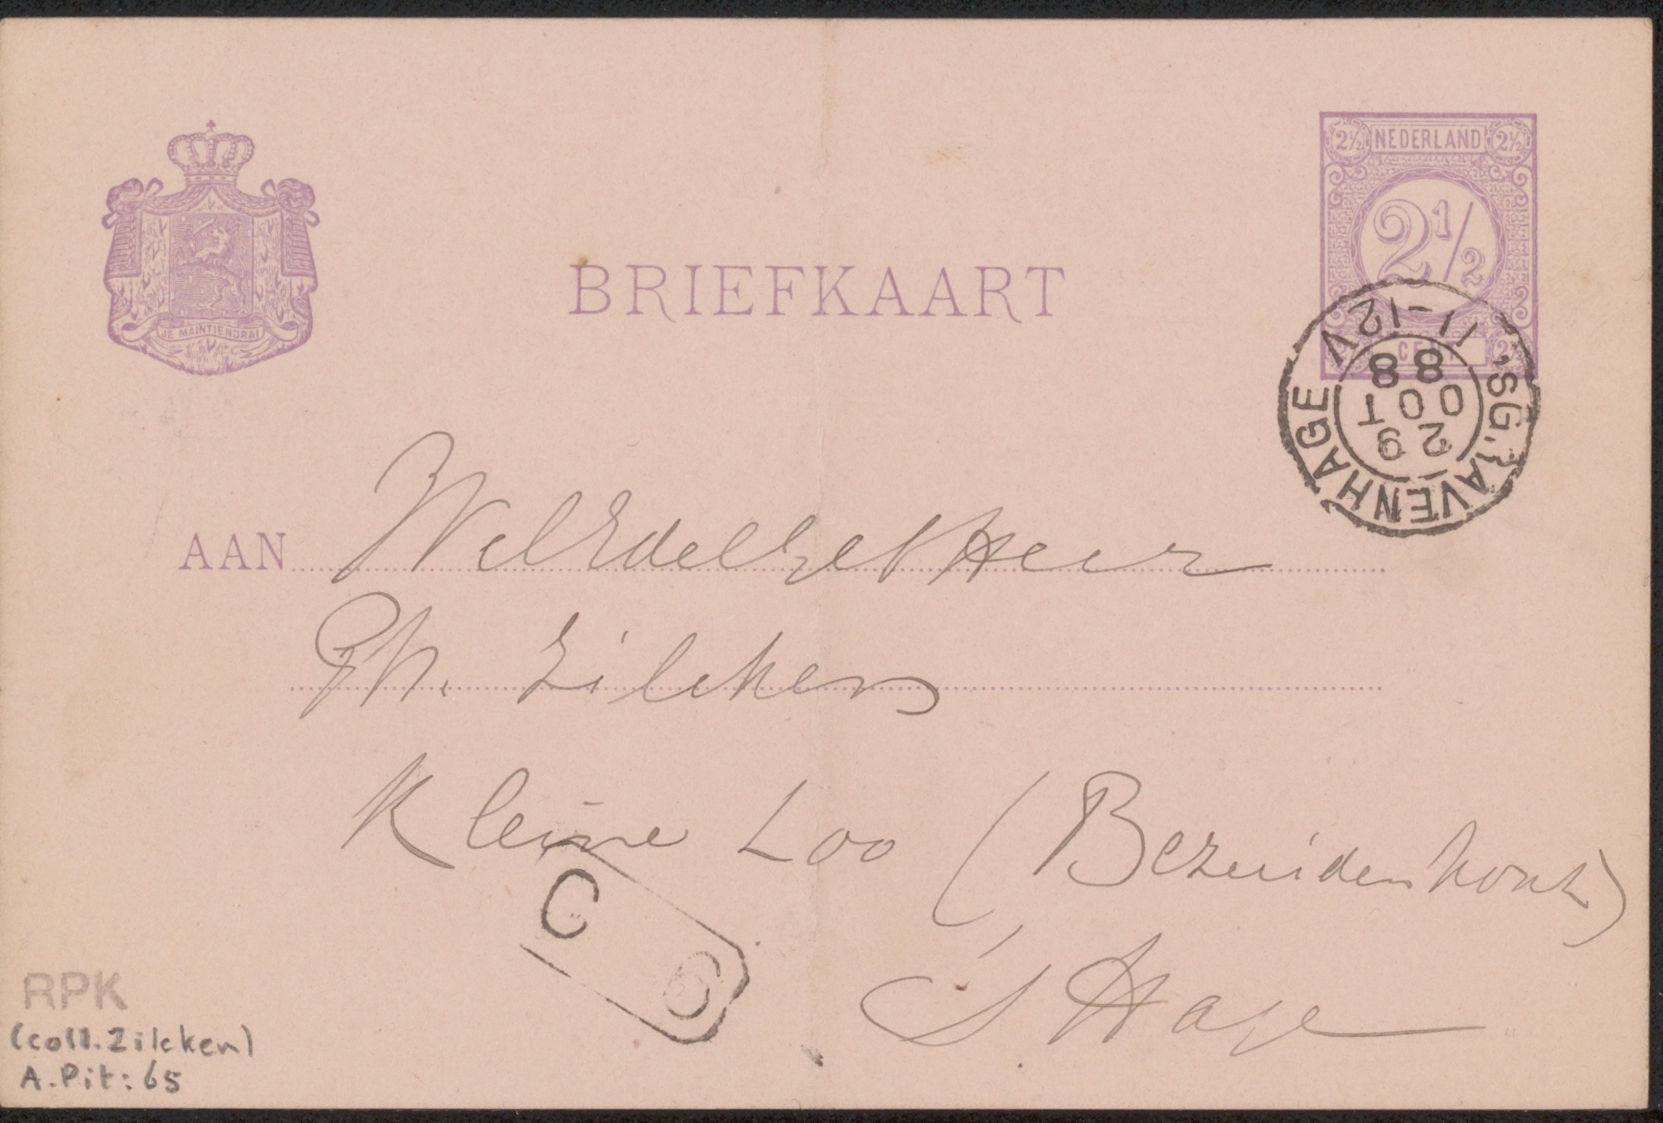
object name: postcard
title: Briefkaart aan Philip Zilcken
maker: adriaan pit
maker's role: print maker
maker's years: 1860-1944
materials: cardboard, ink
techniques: pen, writing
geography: the hague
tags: the hague, painter, draughtsman, philip zilcken, printed matter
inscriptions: collector's mark: ‘RPK’